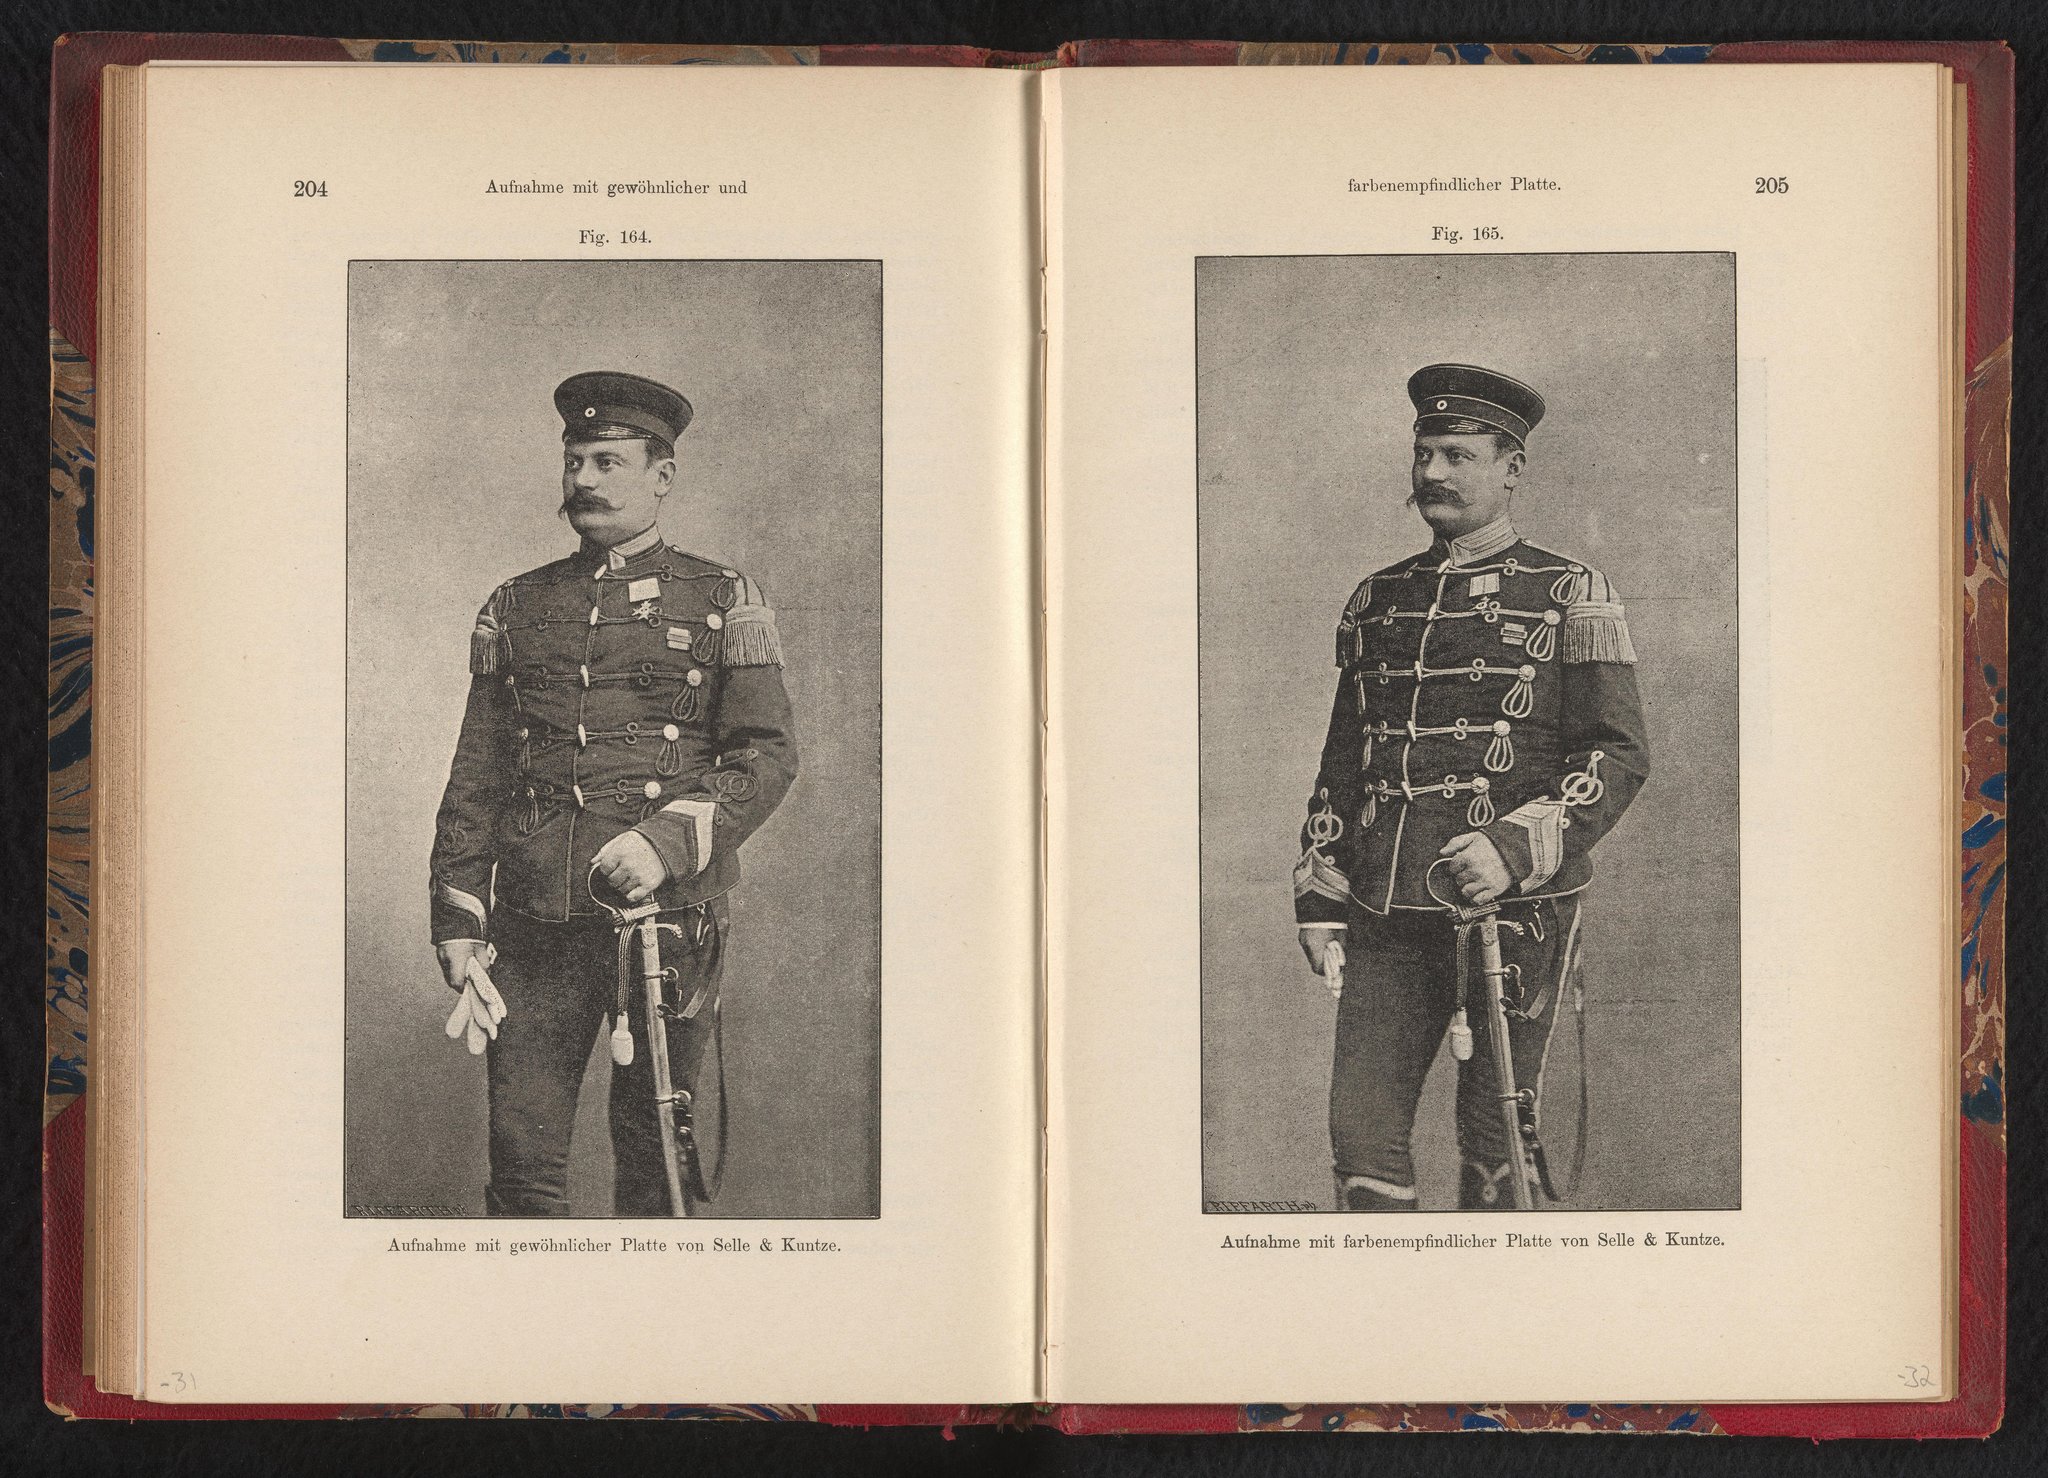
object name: photomechanical print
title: Portret van een onbekende man staand in een militair uniform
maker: heinrich riffarth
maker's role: printer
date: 1886-1891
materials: paper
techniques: autotype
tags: anonymous historical person portrayed alone, (military) uniforms